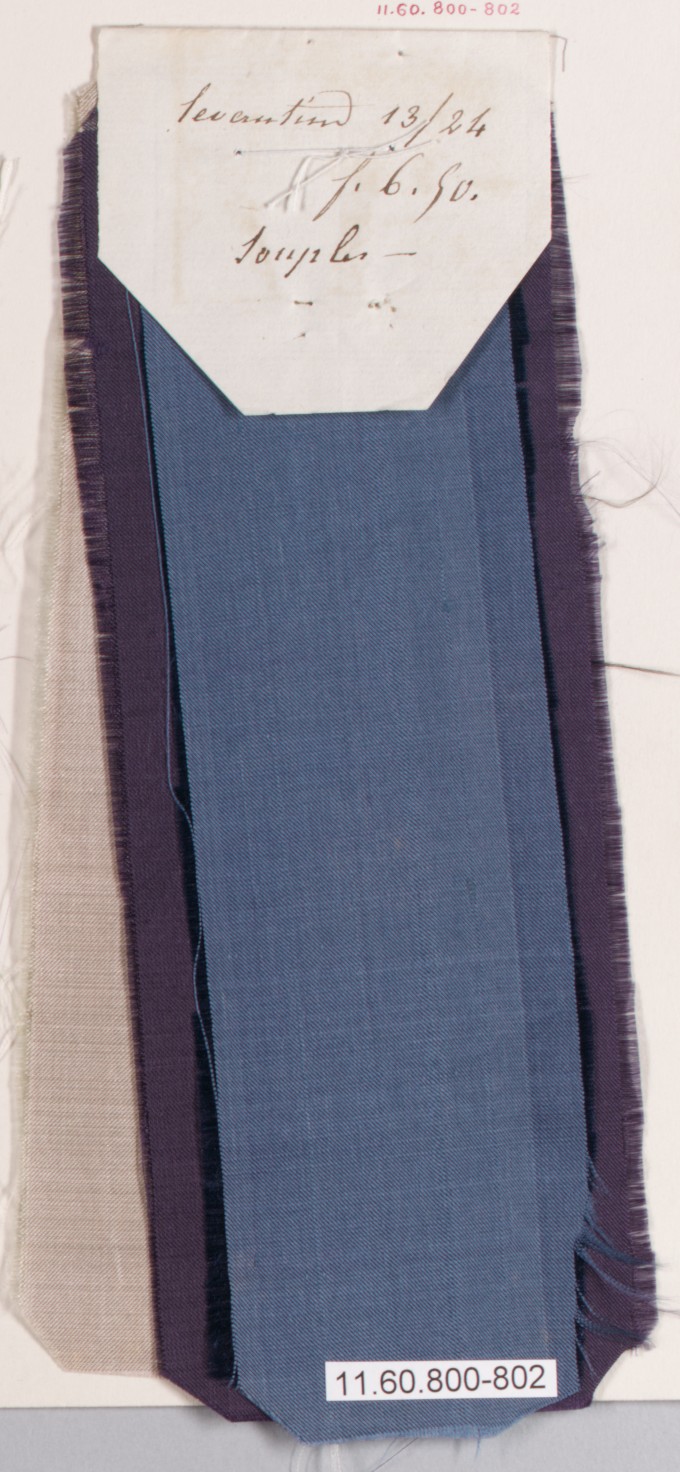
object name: sample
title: Samples (3)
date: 1801-1833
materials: silk